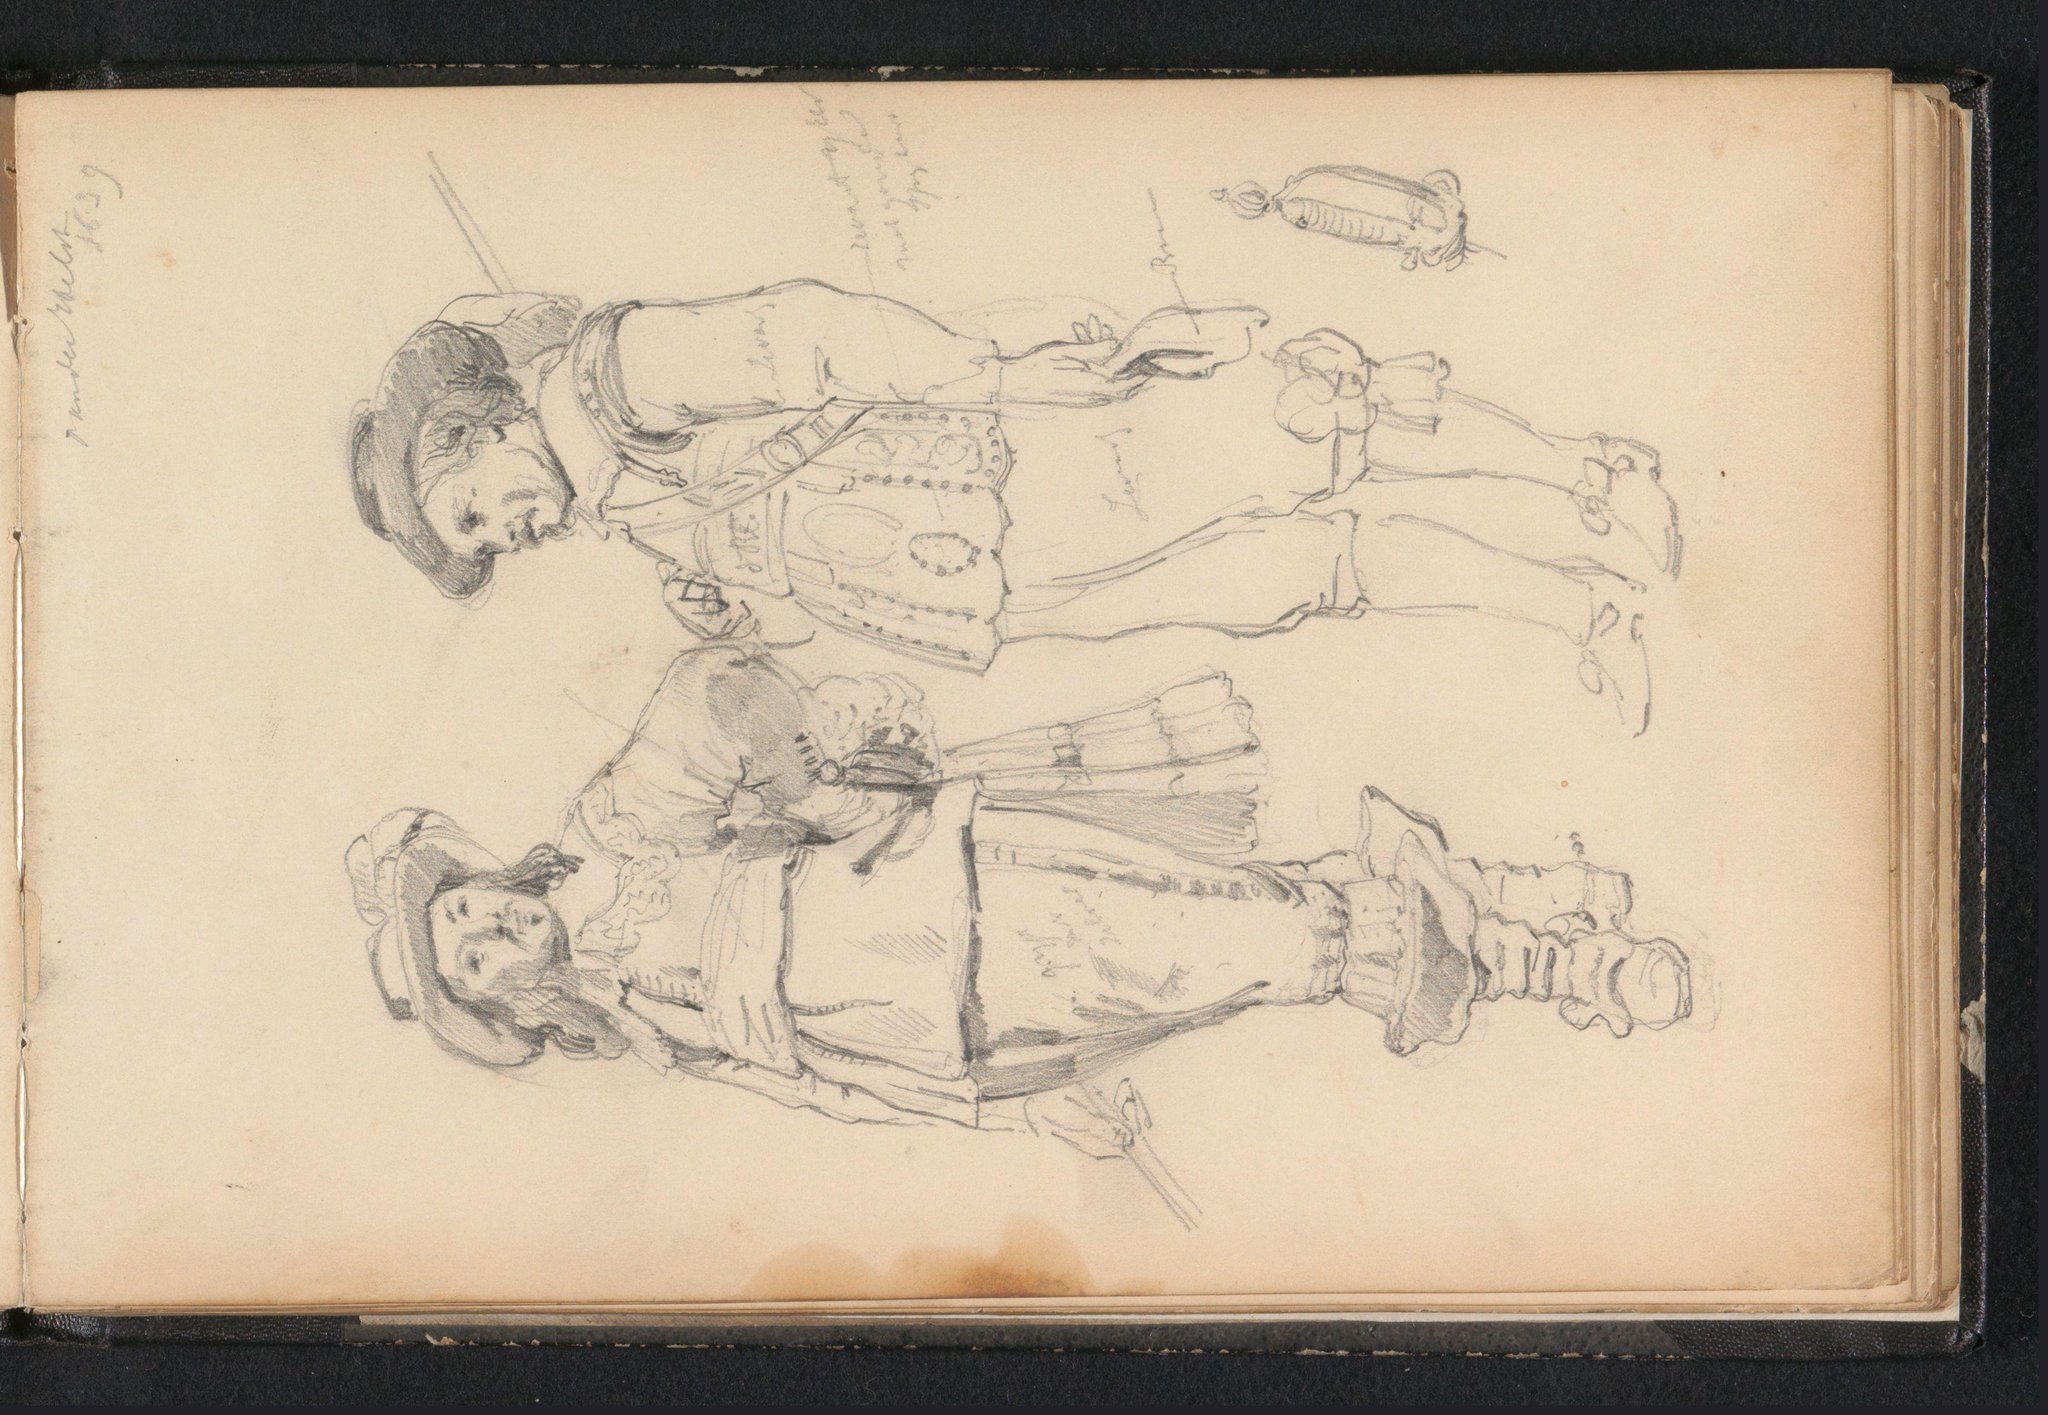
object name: sketchbook leaf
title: Twee schutters in zeventiende-eeuwse kleding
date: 1846-1882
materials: paper, pencil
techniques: stumping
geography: amsterdam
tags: adult man, clothes, costume (+ men's clothes)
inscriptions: annotation: ‘Van der Helst/ 1639’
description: Naar figuren op 'Officieren en andere schutters van wijk VIII in Amsterdam onder leiding van kapitein Roelof Bicker en luitenant Jan Michielsz Blaeuw' van Bartholomeus van der Helst, 1639 (Rijksmuseum Amsterdam).